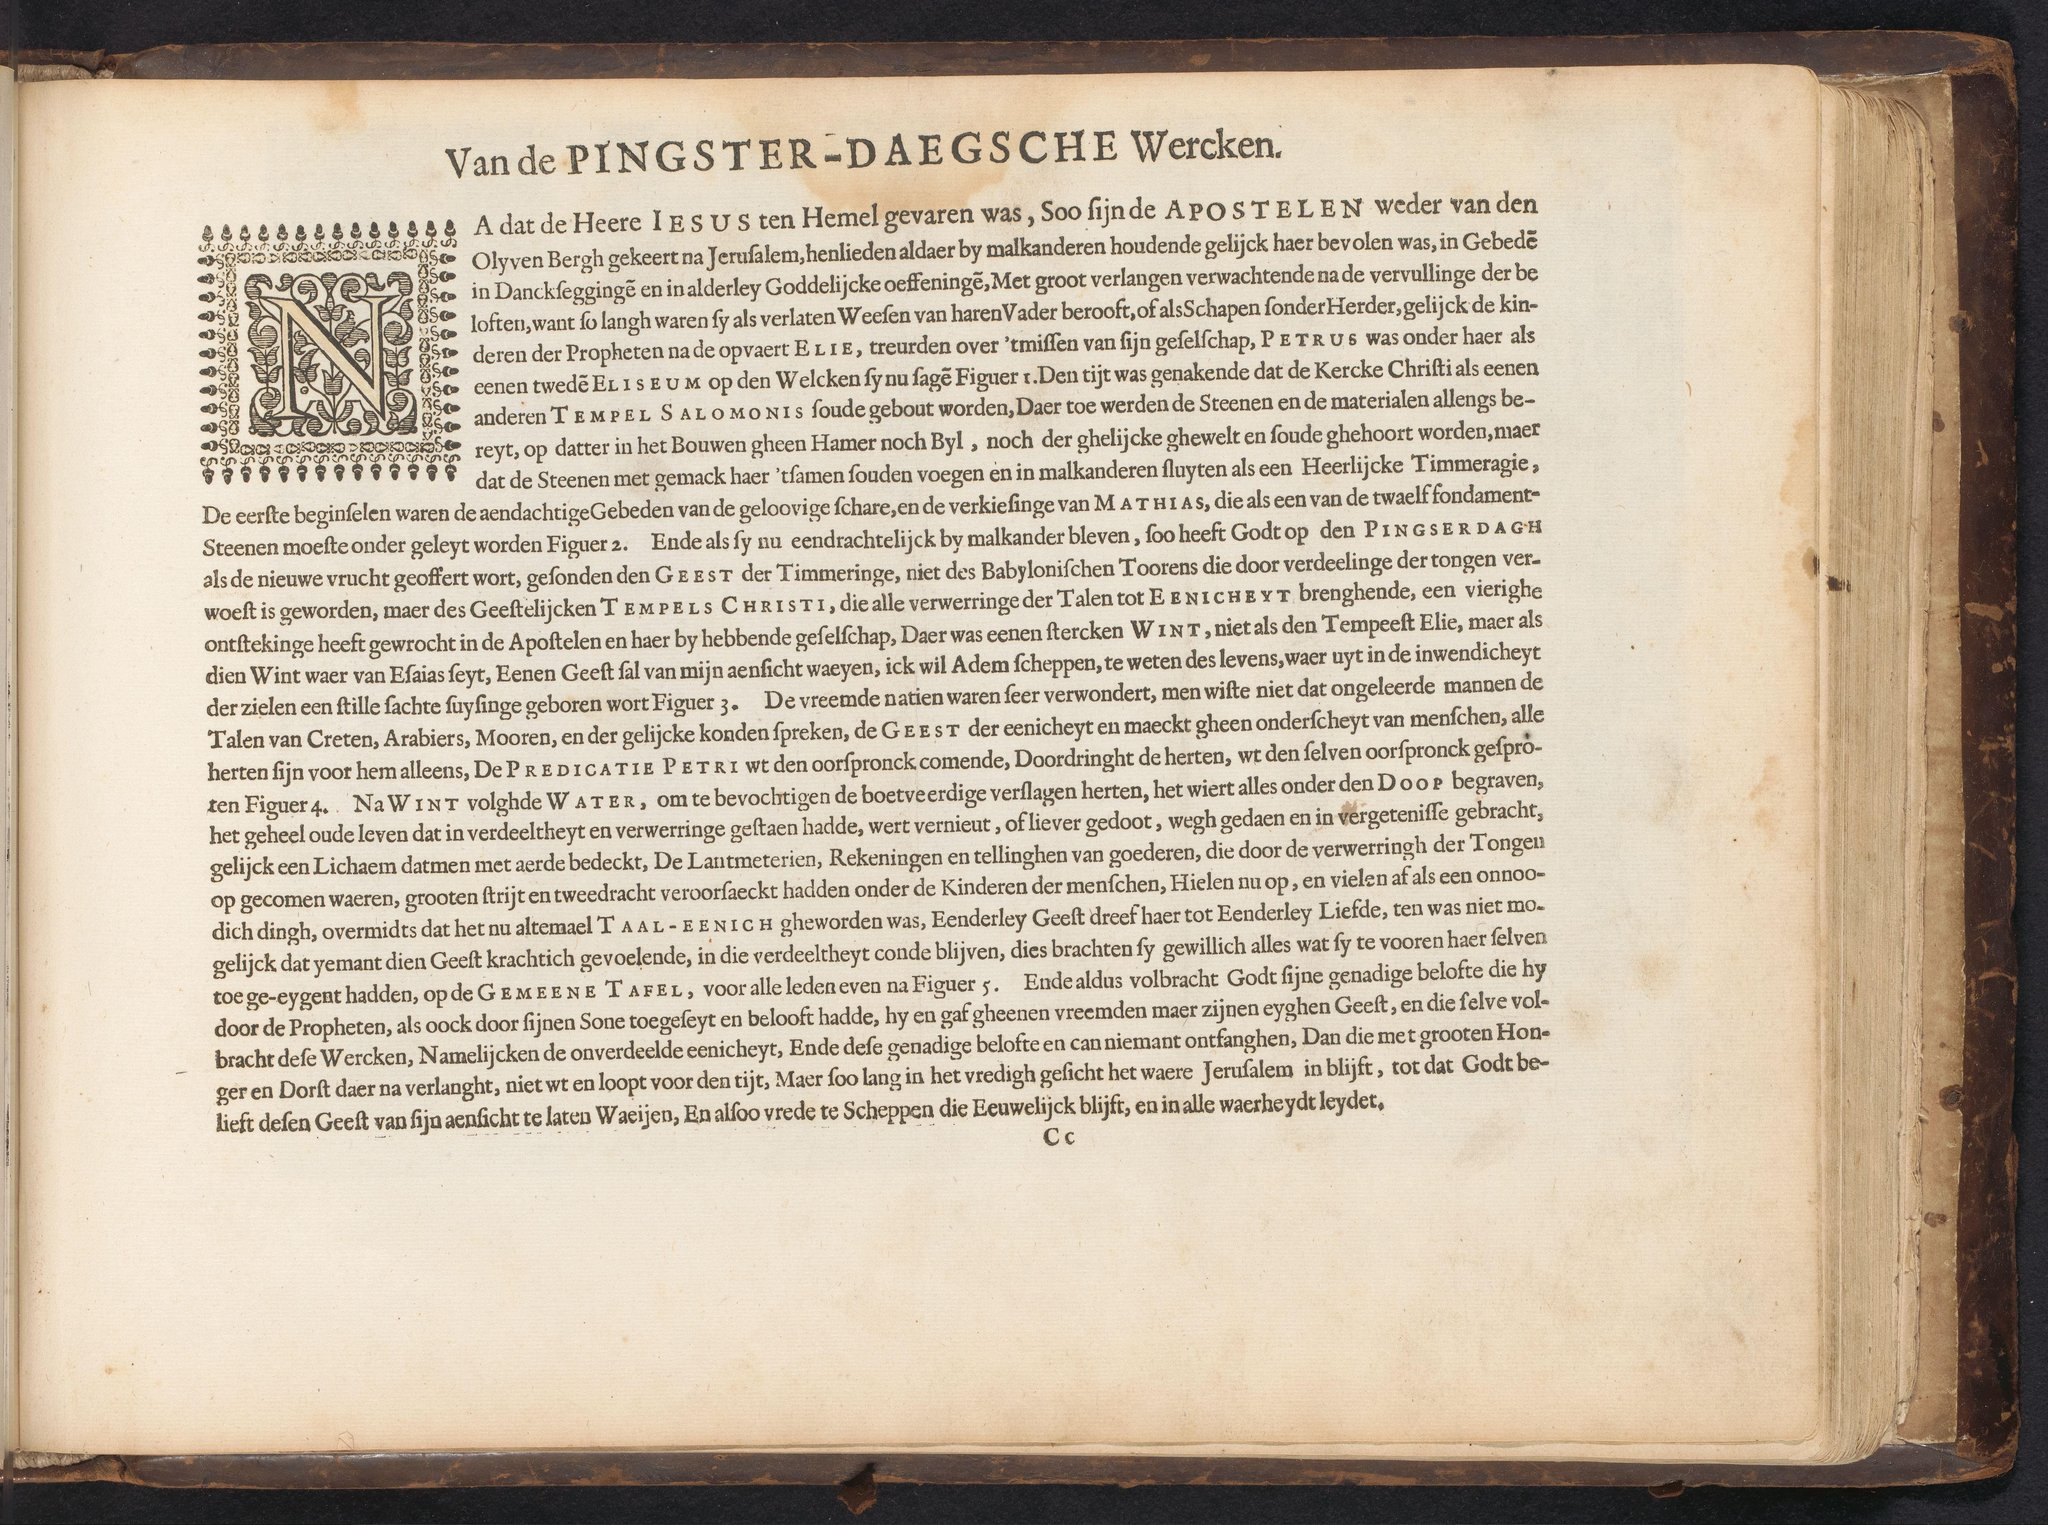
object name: text sheet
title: Van de Pingster-Daegsche Wercken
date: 1646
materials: paper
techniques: hand coloring, letterpress printing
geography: alkmaar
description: Tekstblad bij een serie prenten over Pinksteren. Linksboven initiaal N. Dit blad maakt deel uit van een album.